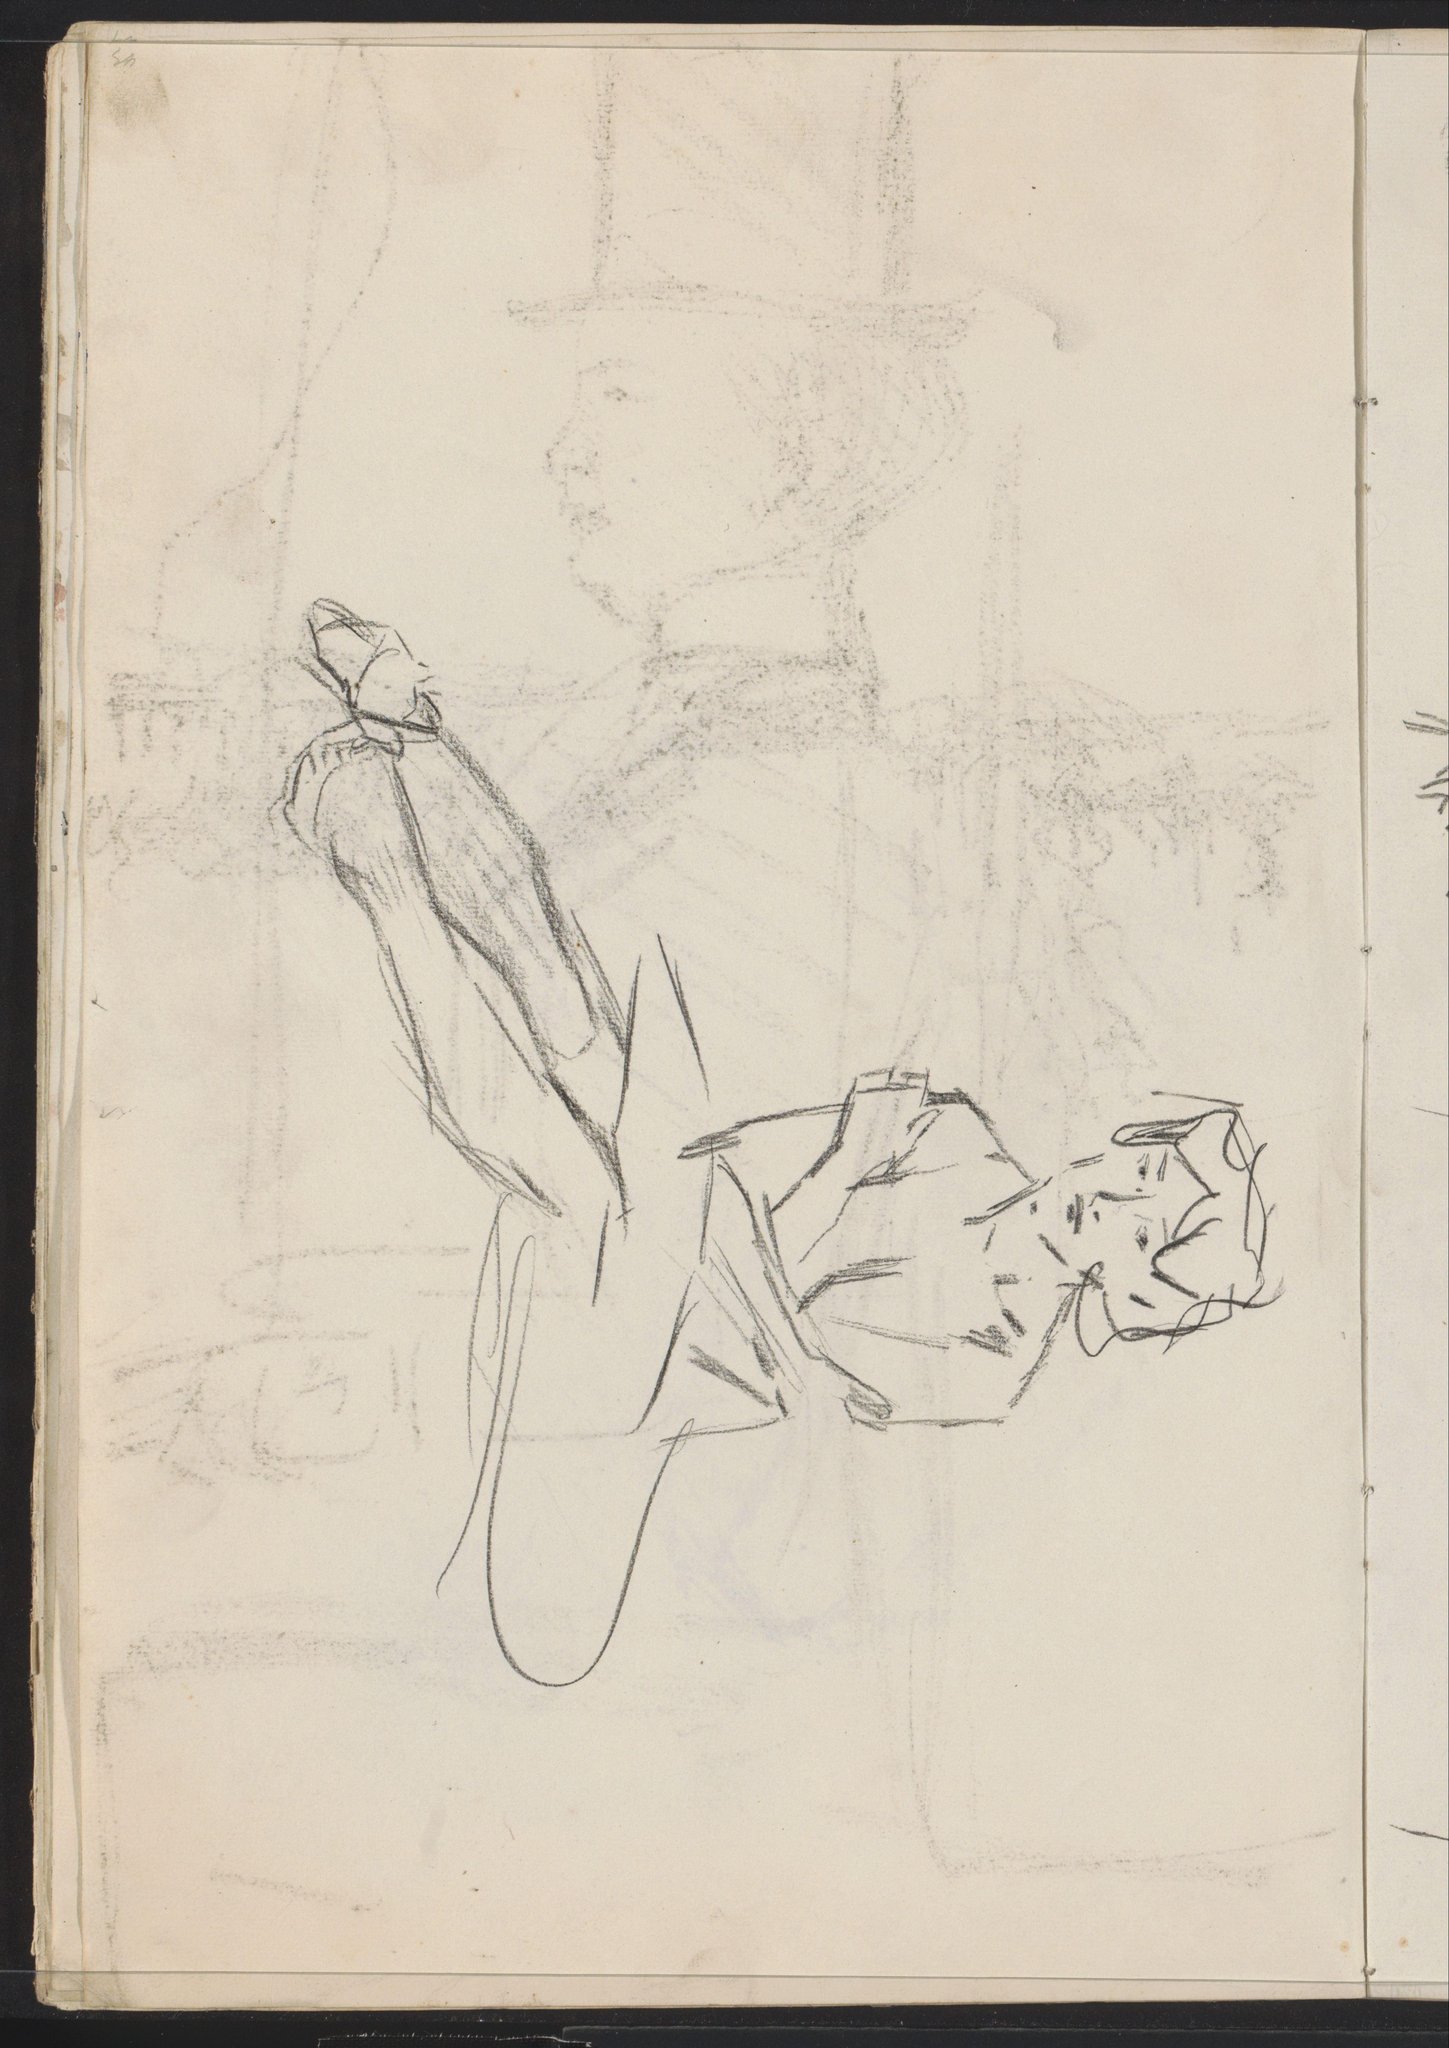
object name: sketchbook leaf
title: Seated Female Nude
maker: isaac israels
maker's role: draughtsman, painter, print maker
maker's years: 1865-1934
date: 1875-1934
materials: chalk, paper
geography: the hague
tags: sitting on the ground - aa - female human figure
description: Ze bedekt haar borsten met haar armen. Blad 8 verso uit schetsboek LXIX met 25 bladen.